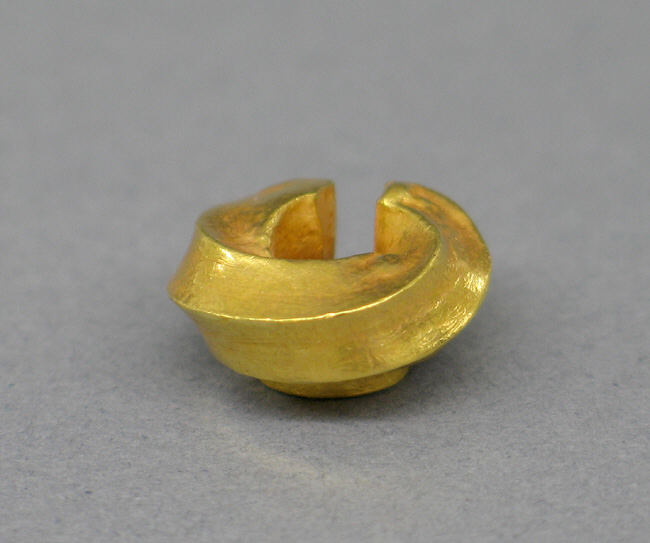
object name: ear ornament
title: Ear Ornament of Twisted Spiral Design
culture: indonesian, javanese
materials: gold